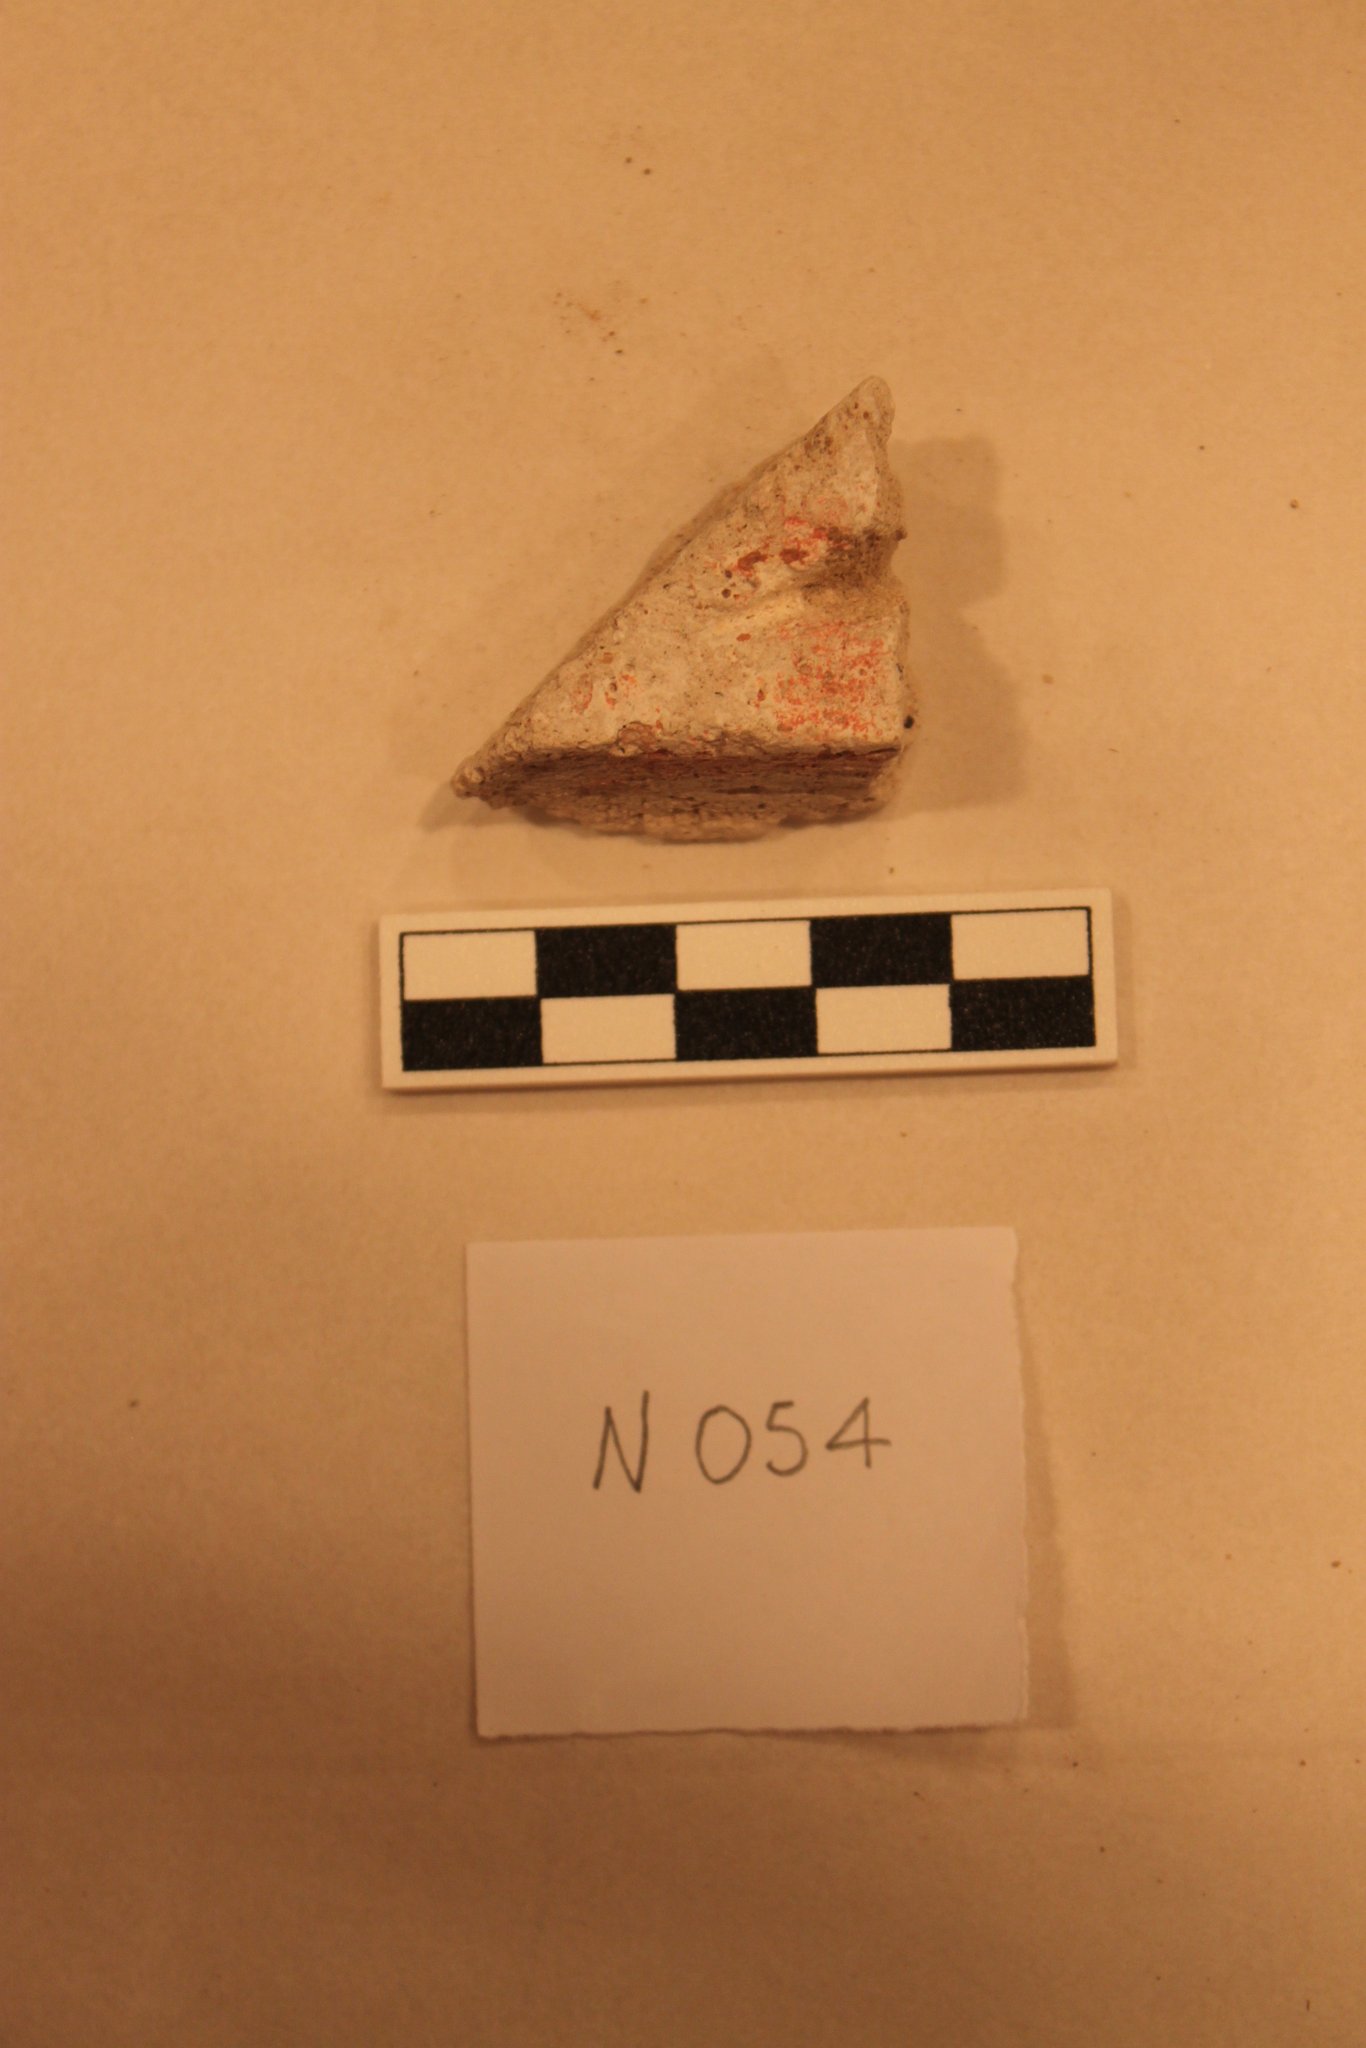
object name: fragment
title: Stucco Fragment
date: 701-1200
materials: plaster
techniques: carving, painting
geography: iran